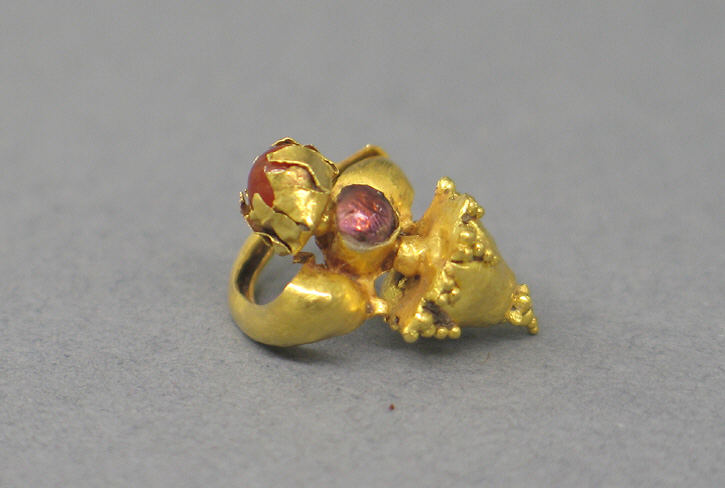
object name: ear clip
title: Pair of Ear Clips with Pale Red Stones and Granulate Design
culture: indonesian, javanese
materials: gold